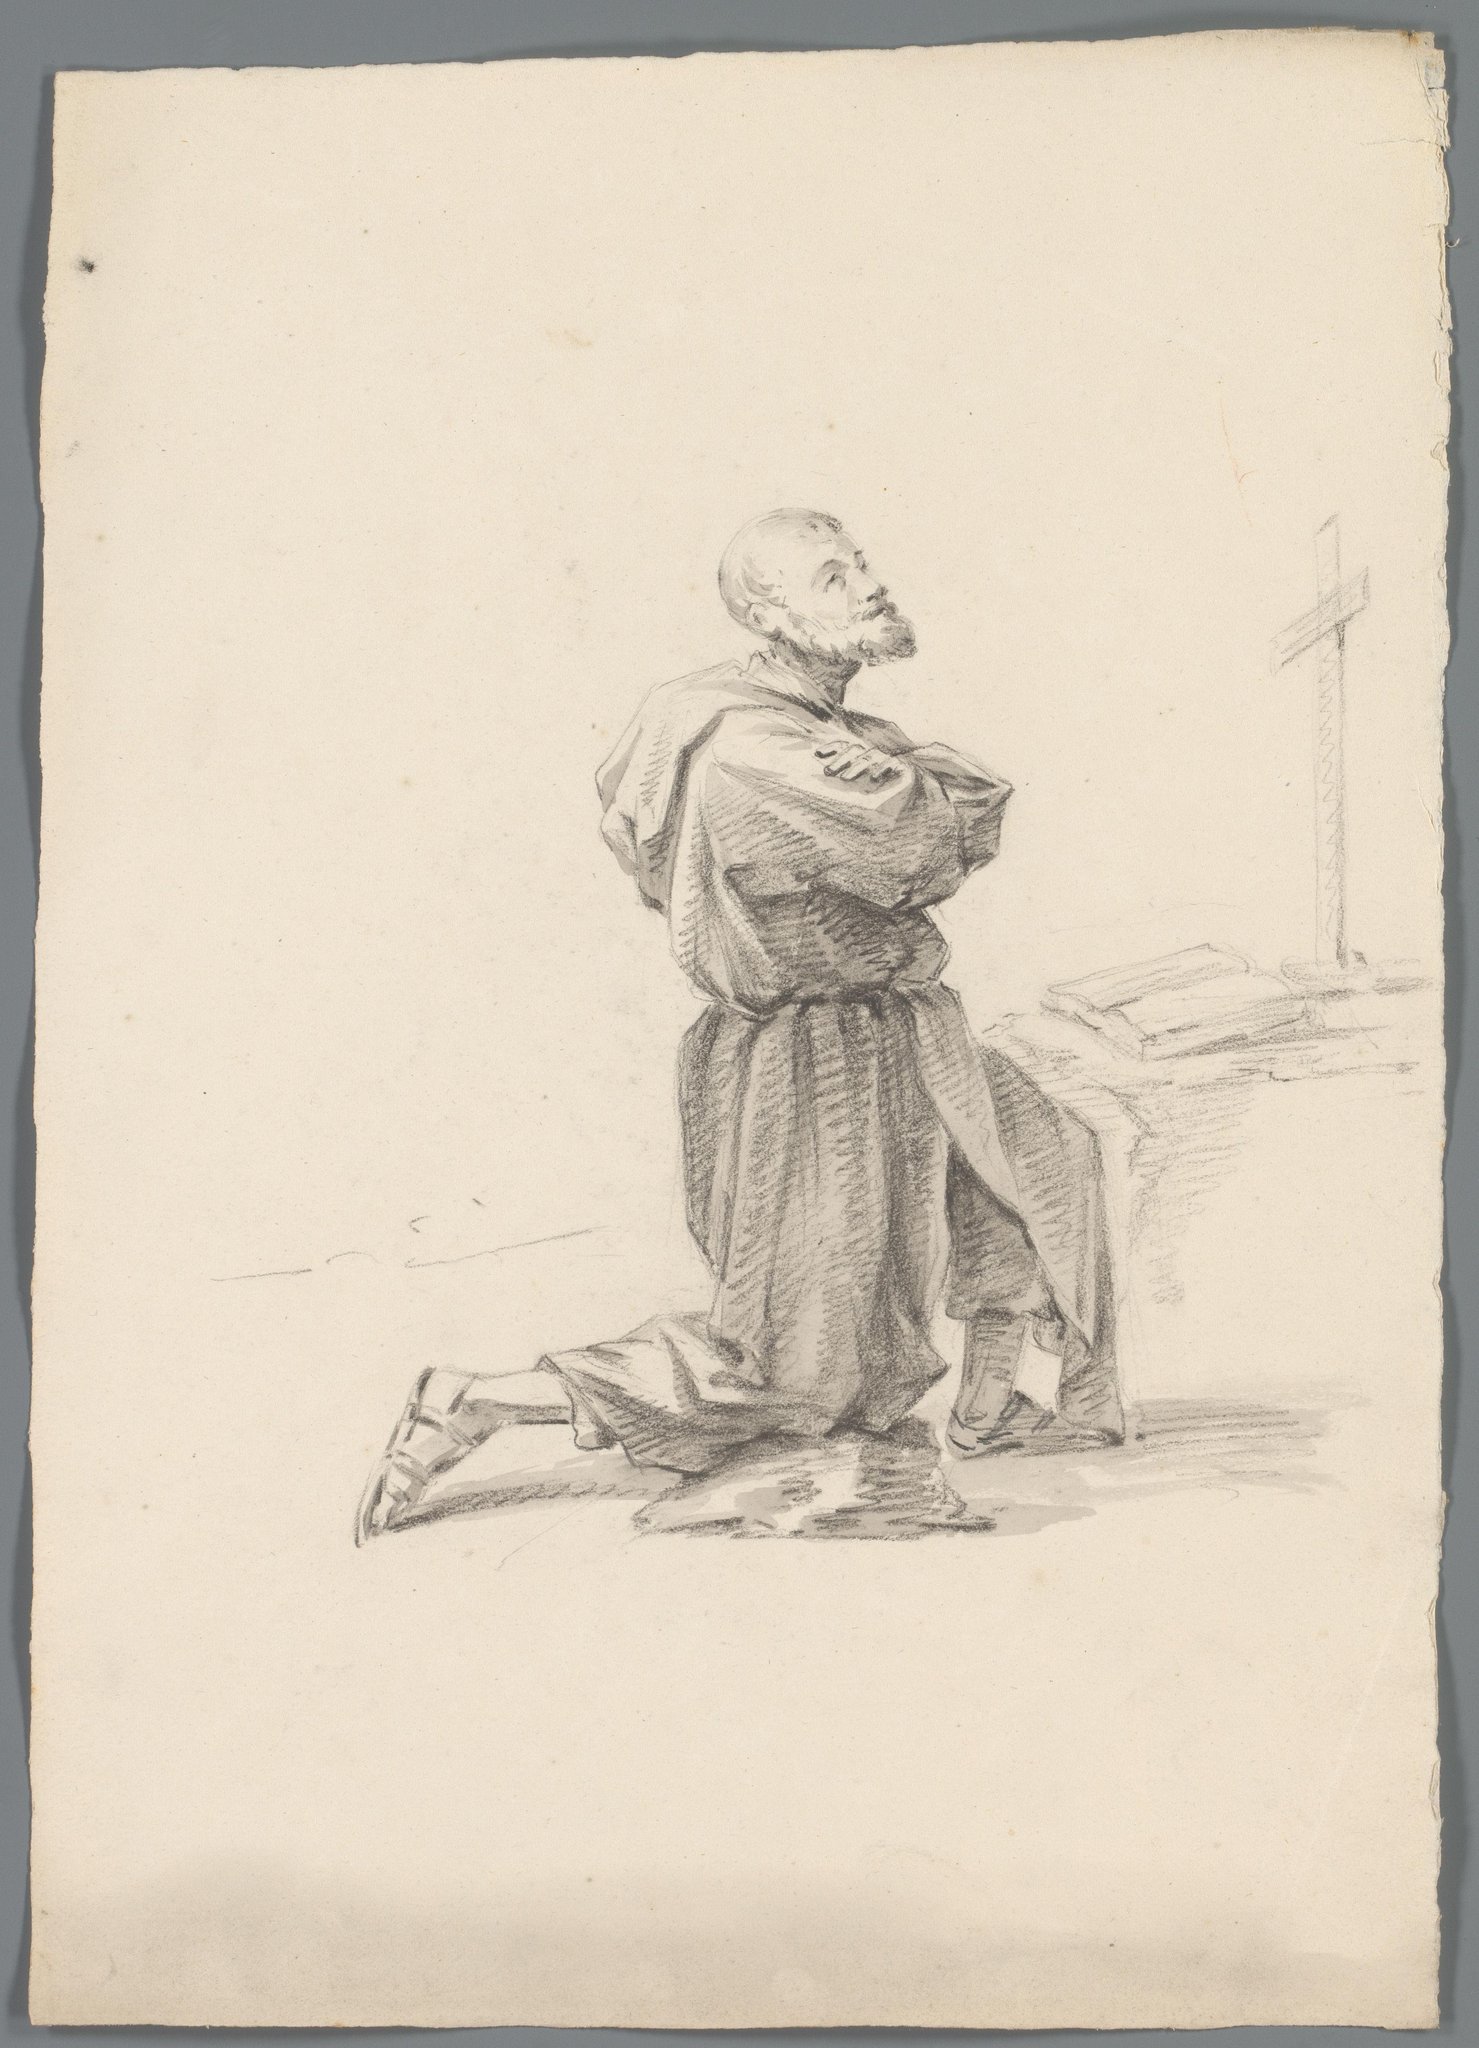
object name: drawing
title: Geknielde monnik of pelgrim voor een boek en kruis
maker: Anonymous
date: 1820-1830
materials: chalk, paper, watercolor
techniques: brush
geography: the hague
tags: book, crucifix ~ personal devotion, kneeling figure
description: Tekeningen waarschijnlijk ontstaan bij het Haagse kunstgenootschap ‘Tot Nut der Tekenkunst’, waar twee keer per week tekenavonden werden georganiseerd met geklede modellen.